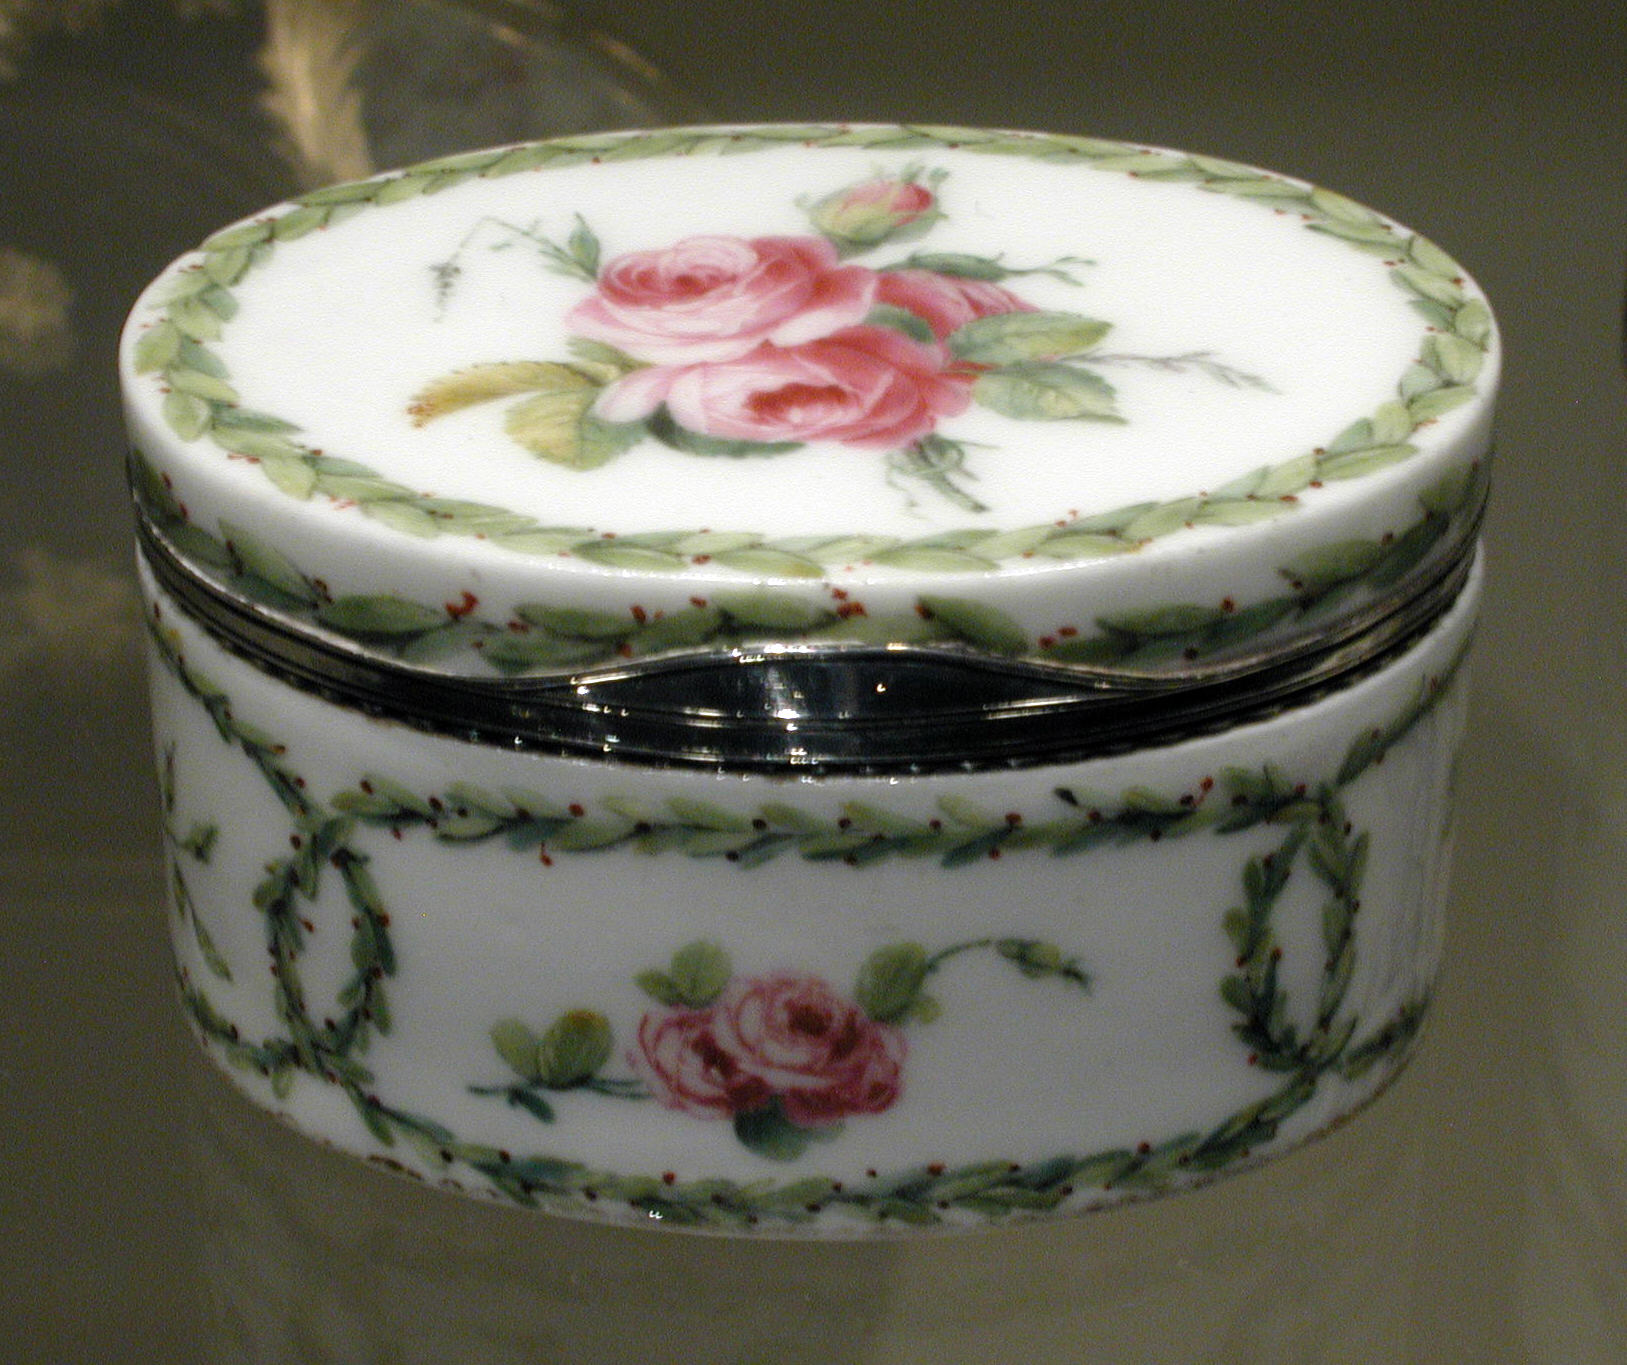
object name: snuffbox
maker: sèvres manufactory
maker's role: manufactory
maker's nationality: french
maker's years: 1740-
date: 1765-1770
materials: silver, soft paste porcelain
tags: roses